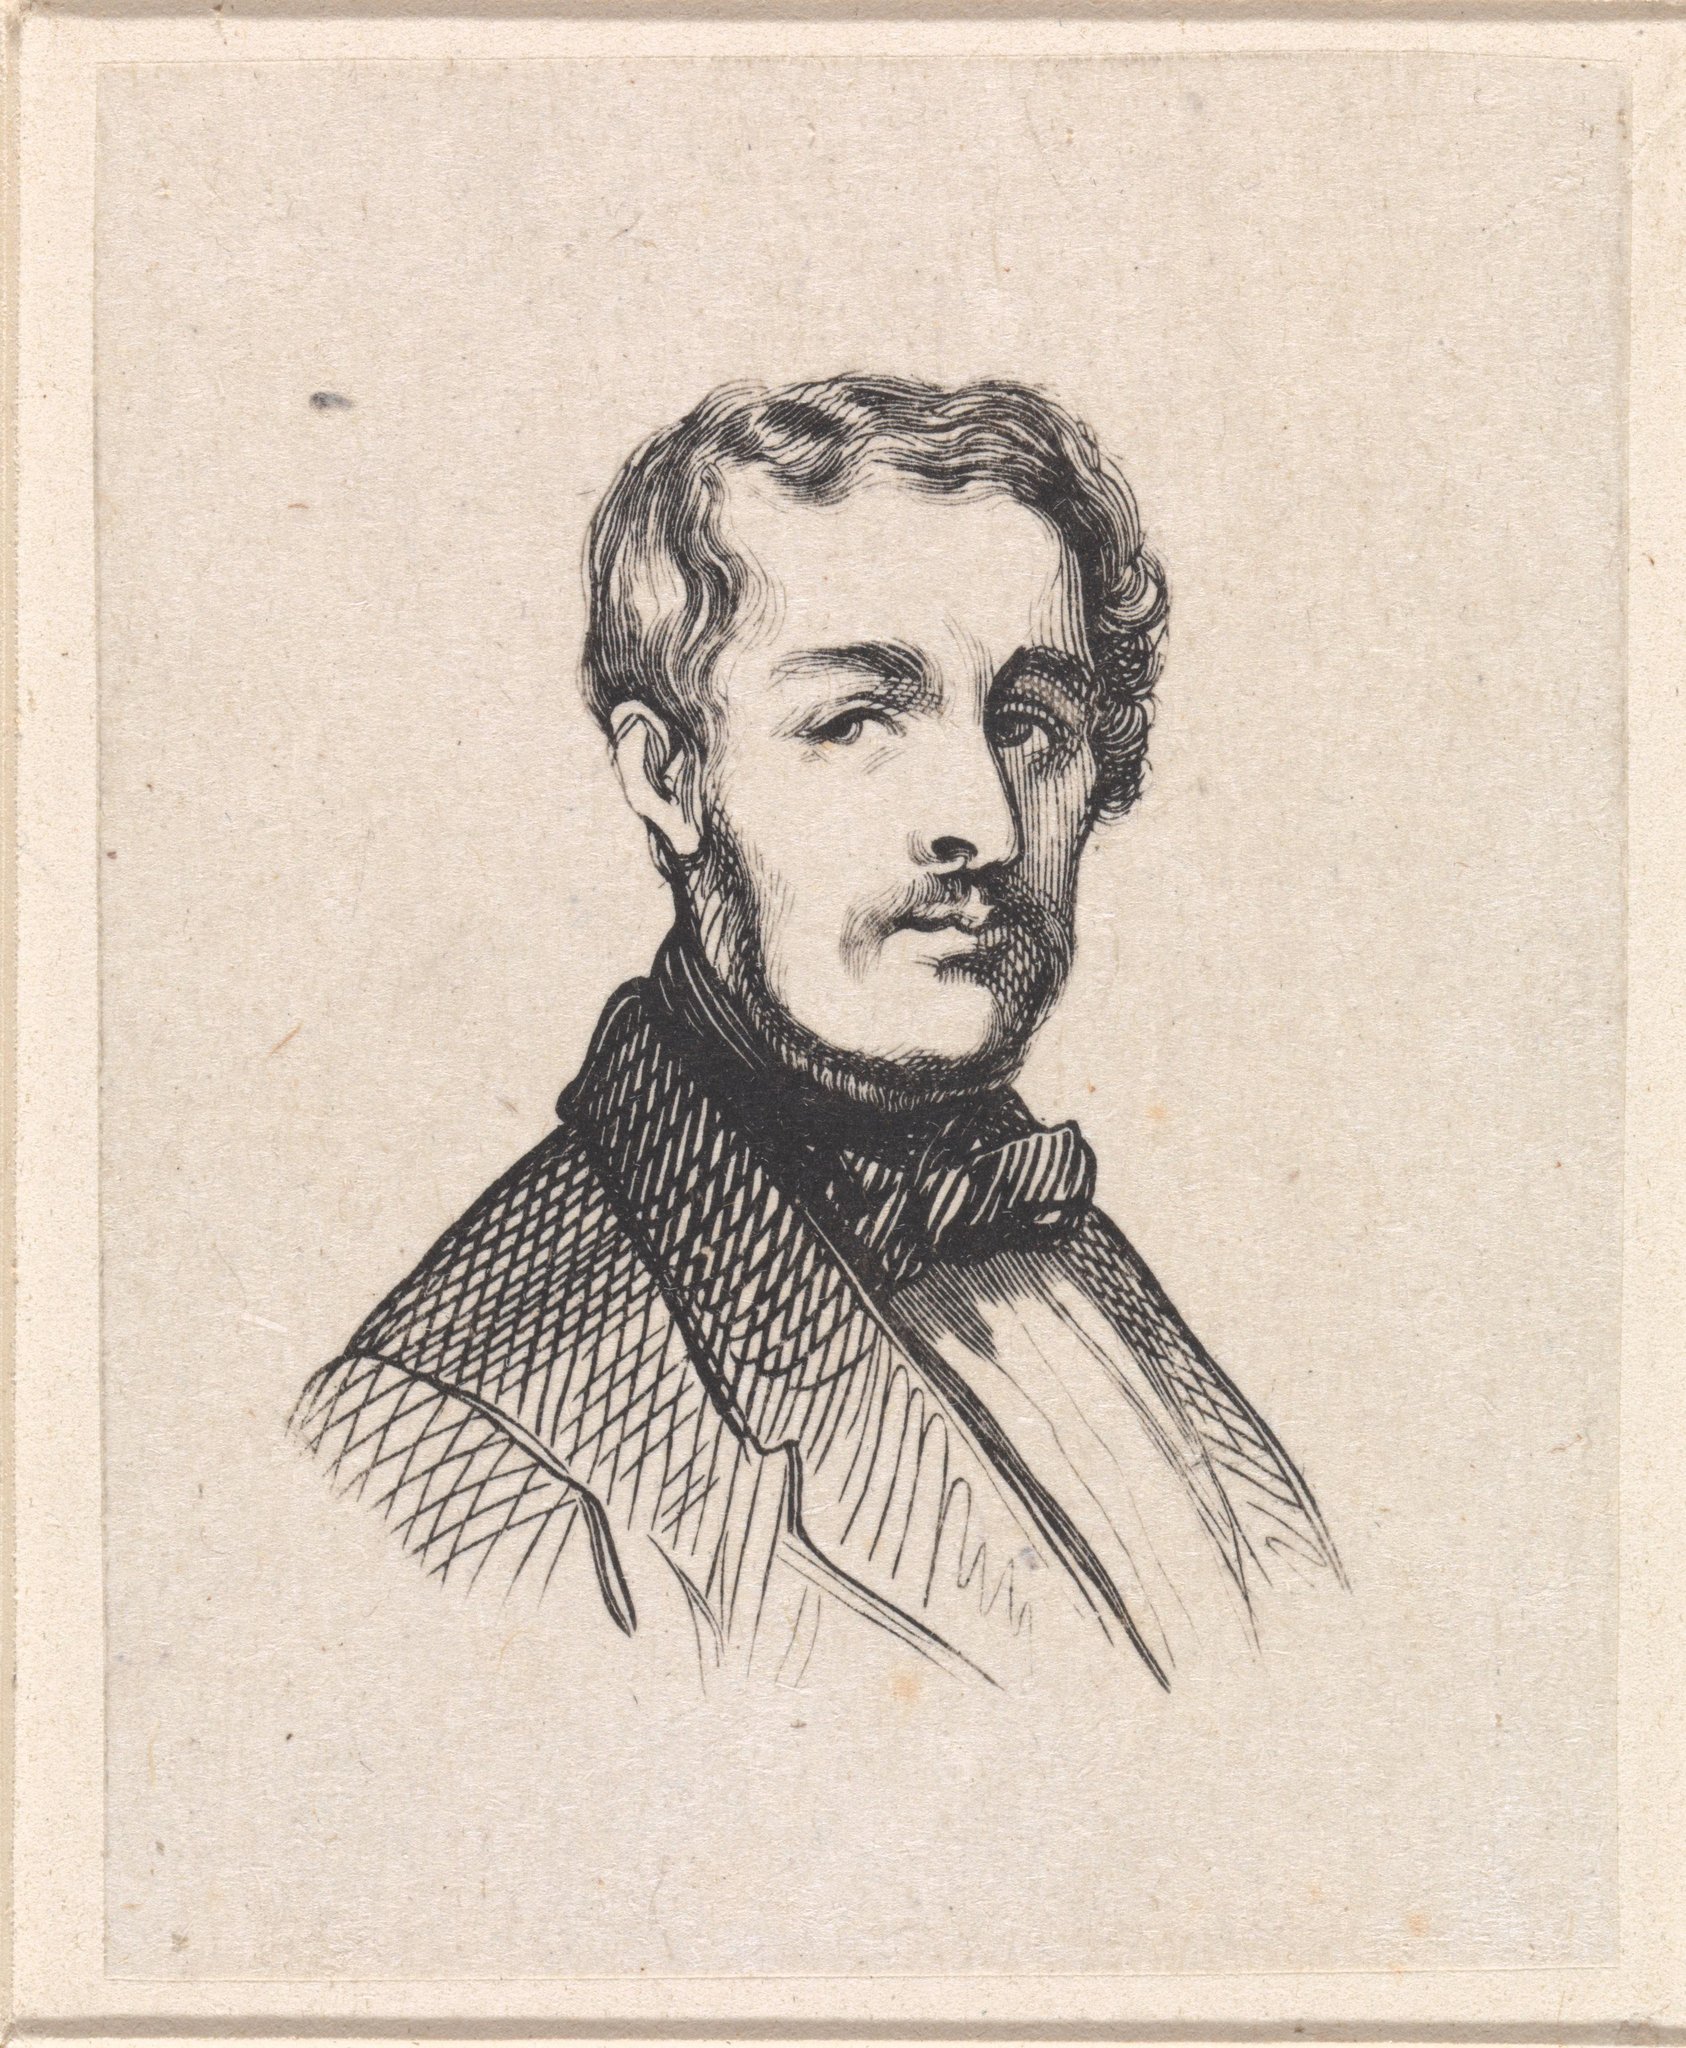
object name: print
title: Portret van Erin Corr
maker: Anonymous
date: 1841-1842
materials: paper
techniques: engraving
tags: brussels, paris, print maker, erin corr, historical persons, portrait, self-portrait of painter, portrait, self-portrait of artist, portrait, self-portrait of draughtsman